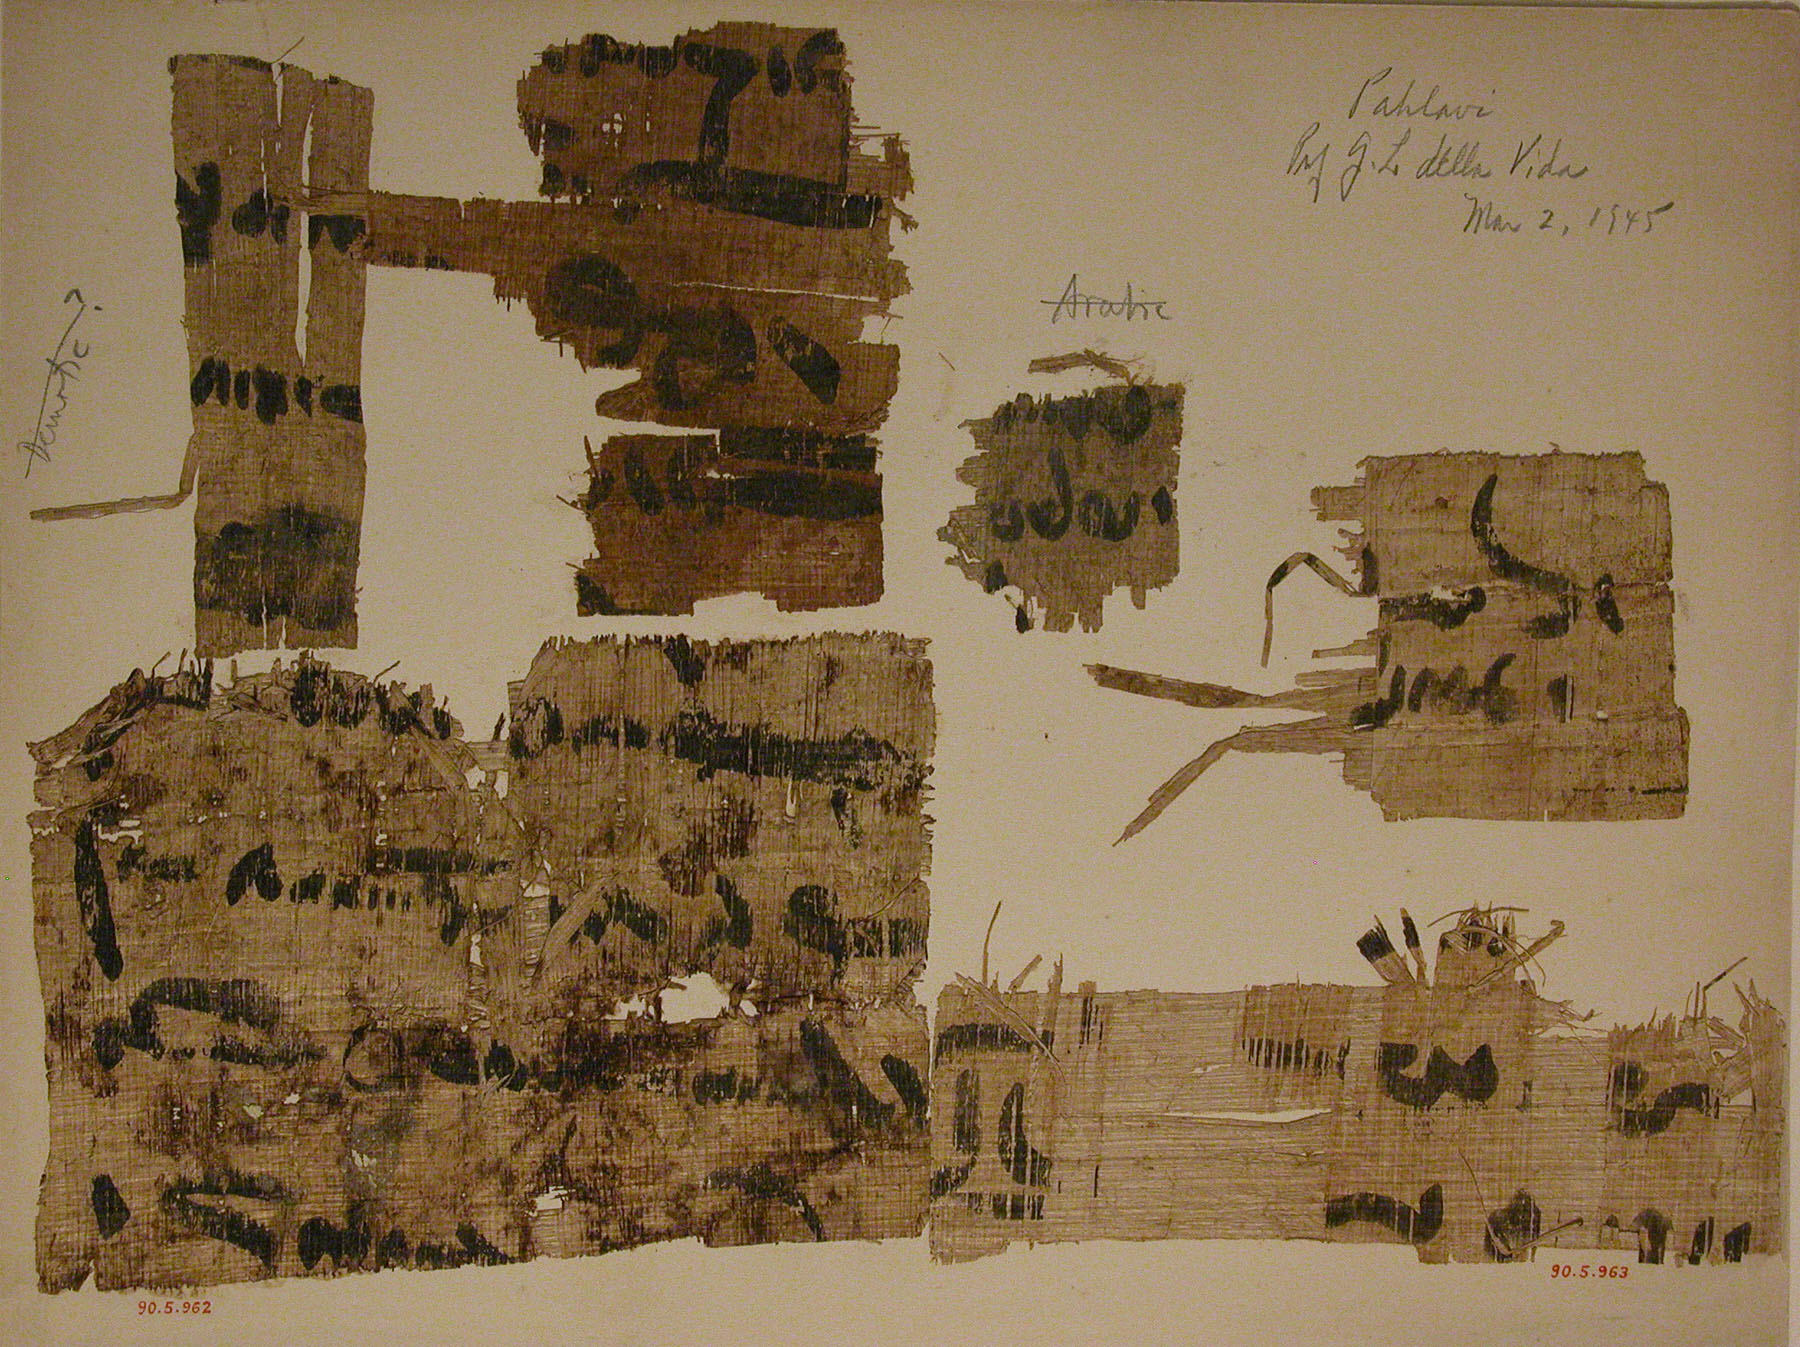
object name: non illustrated single work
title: Fragment of a Letter in Pahlavi Script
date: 618-629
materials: ink, papyrus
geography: egypt